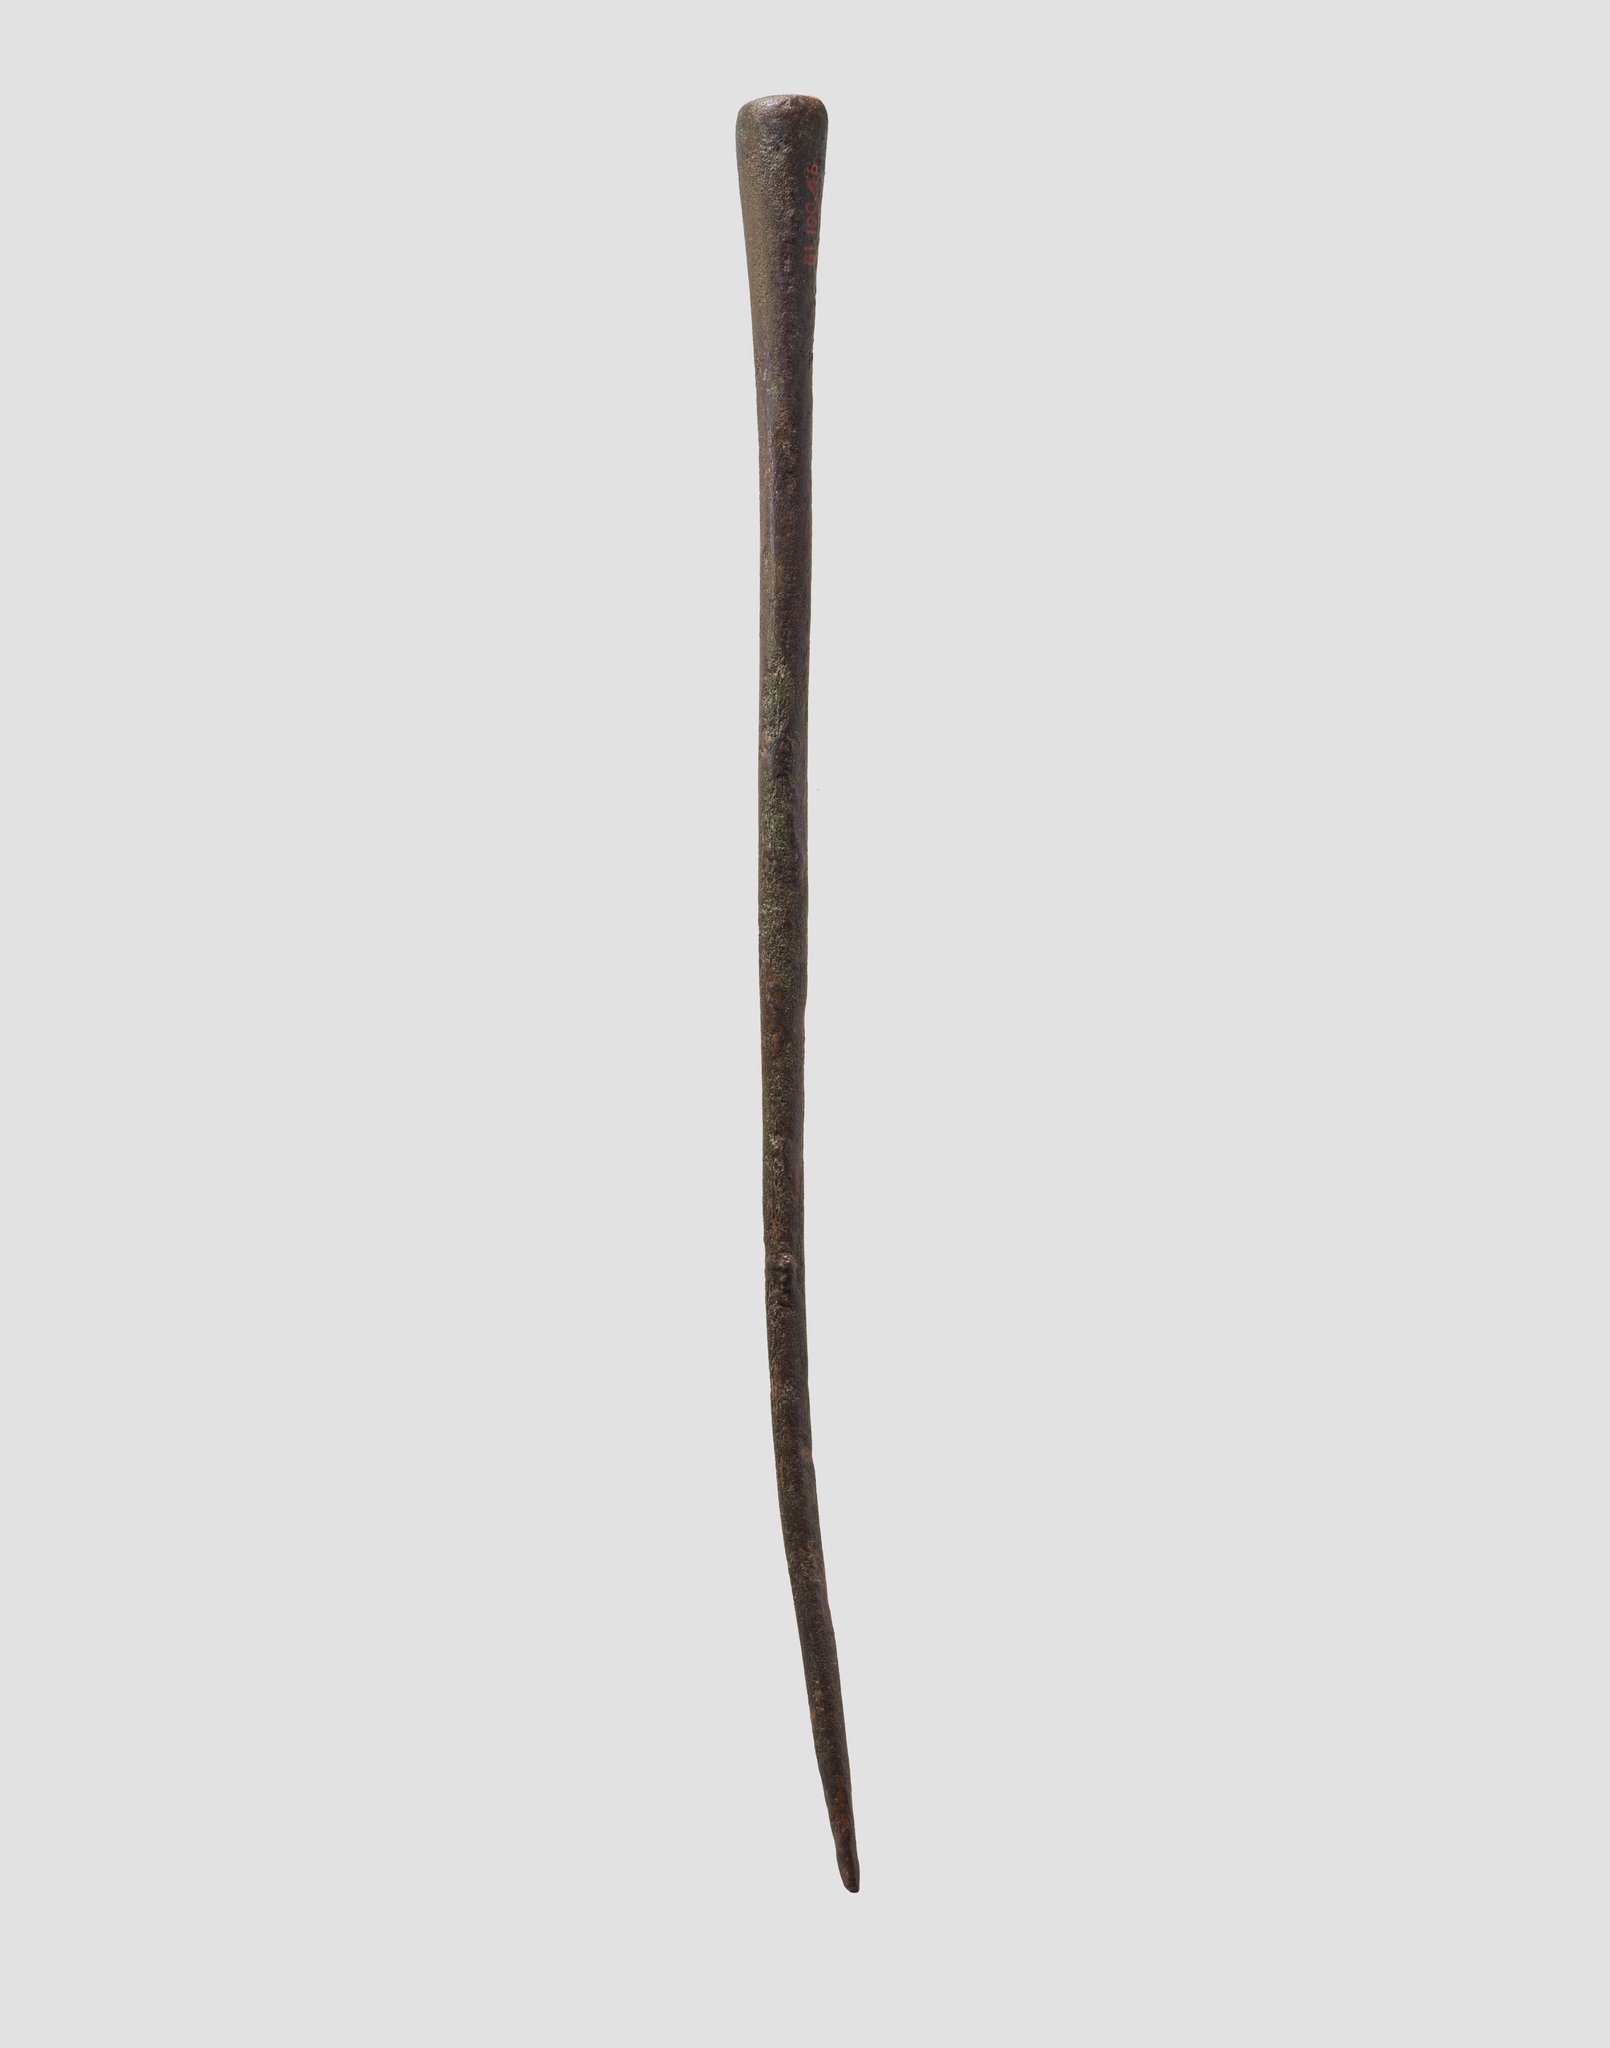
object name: pin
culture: iranian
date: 900-801 BCE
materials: bronze, copper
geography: iran